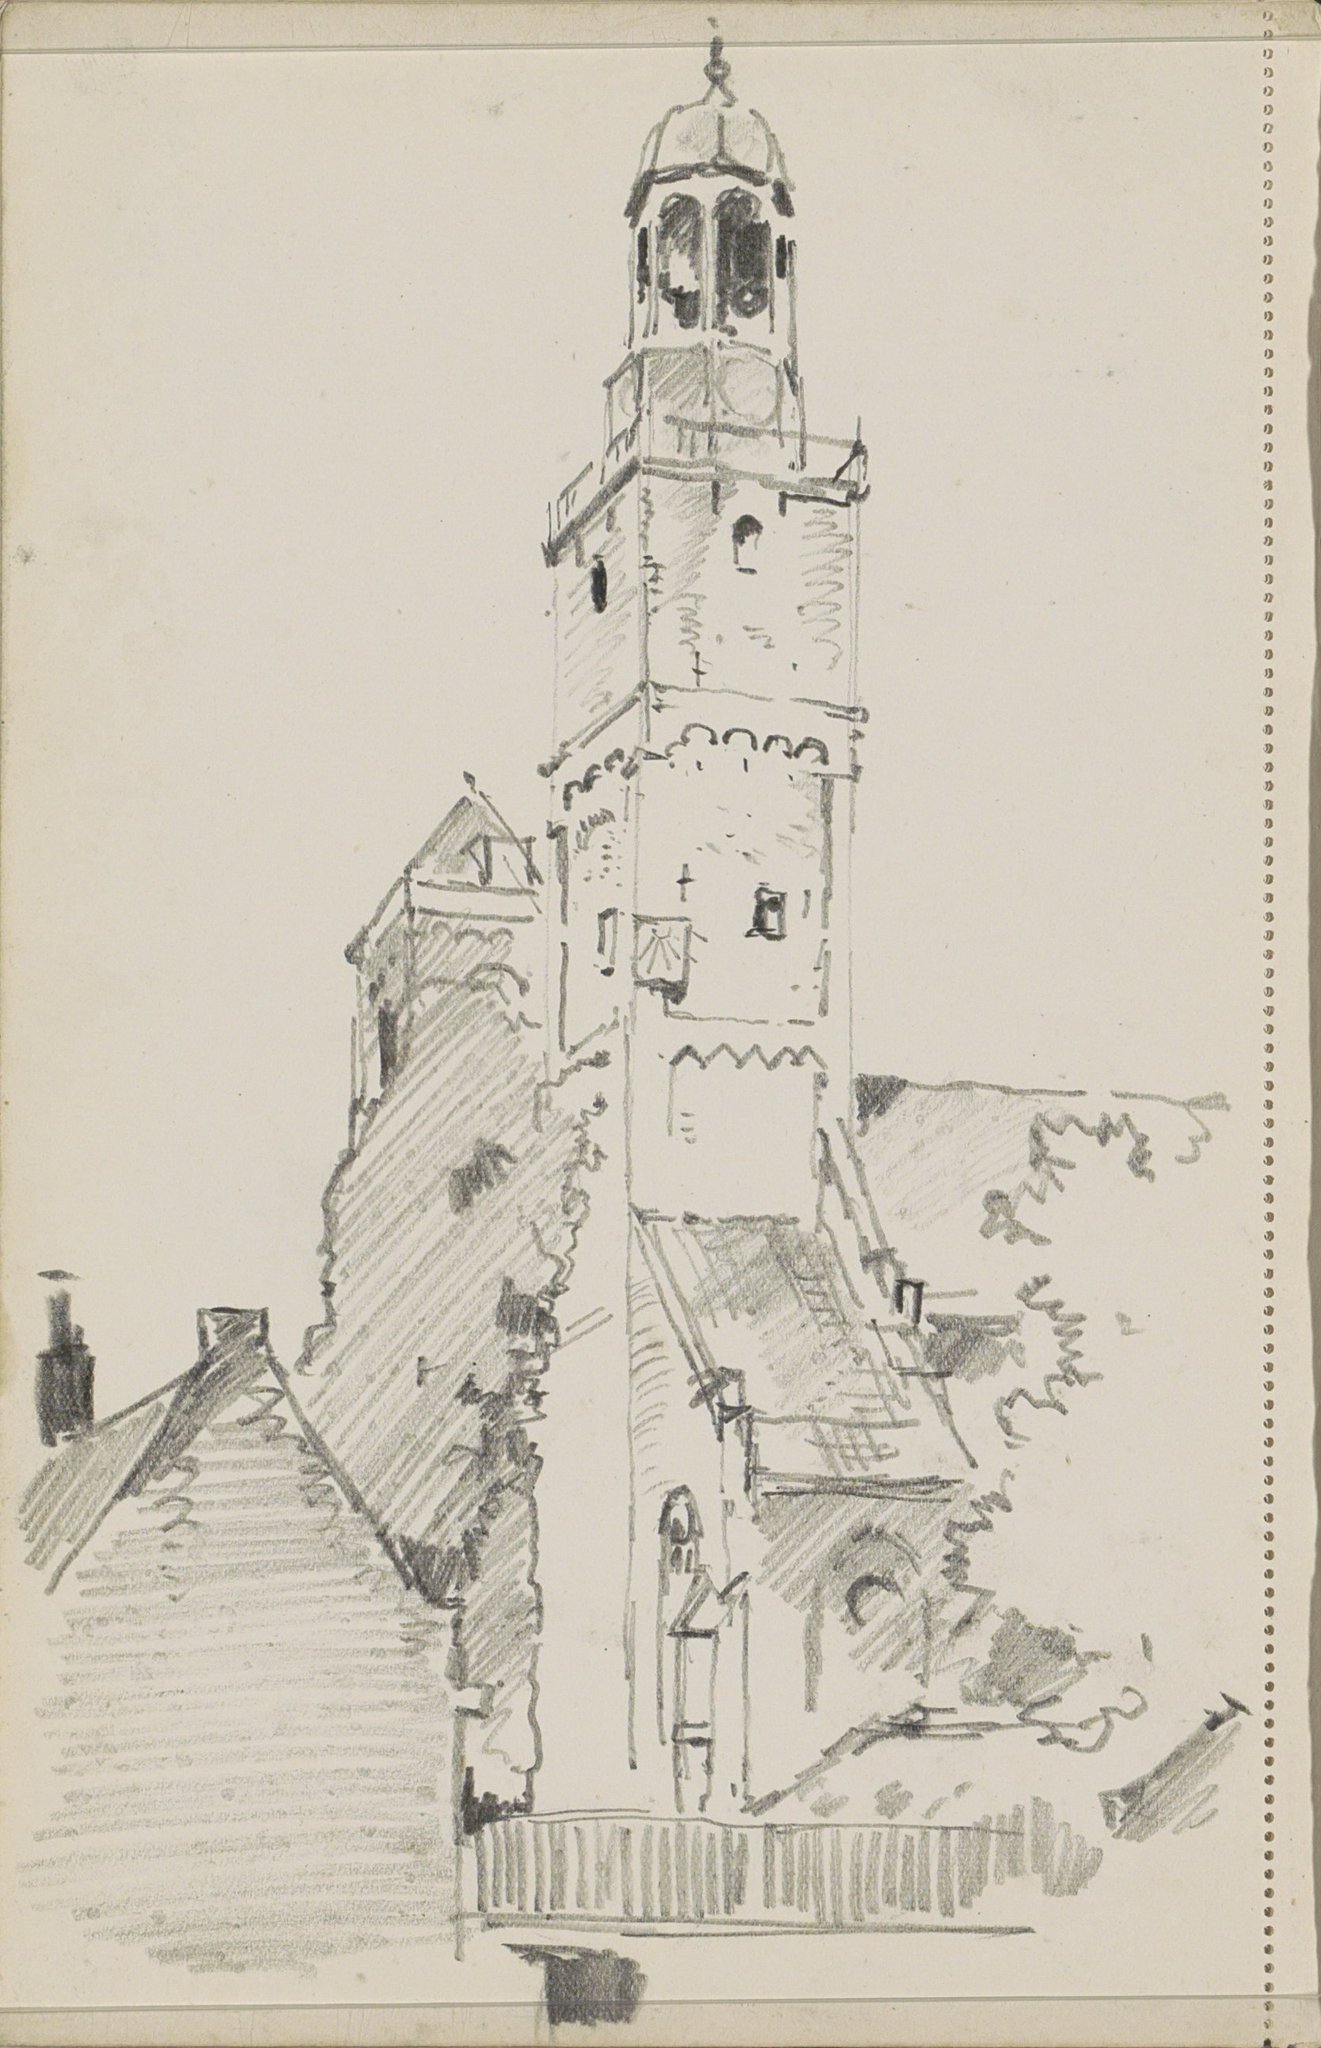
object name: sketchbook leaf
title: Gebouw met twee torens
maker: cornelis vreedenburgh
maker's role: draughtsman, print maker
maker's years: 1880-1946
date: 1890-1946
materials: paper, pencil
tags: tower (of house or building)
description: Blad 51 verso uit een schetsboek met 61 bladen.